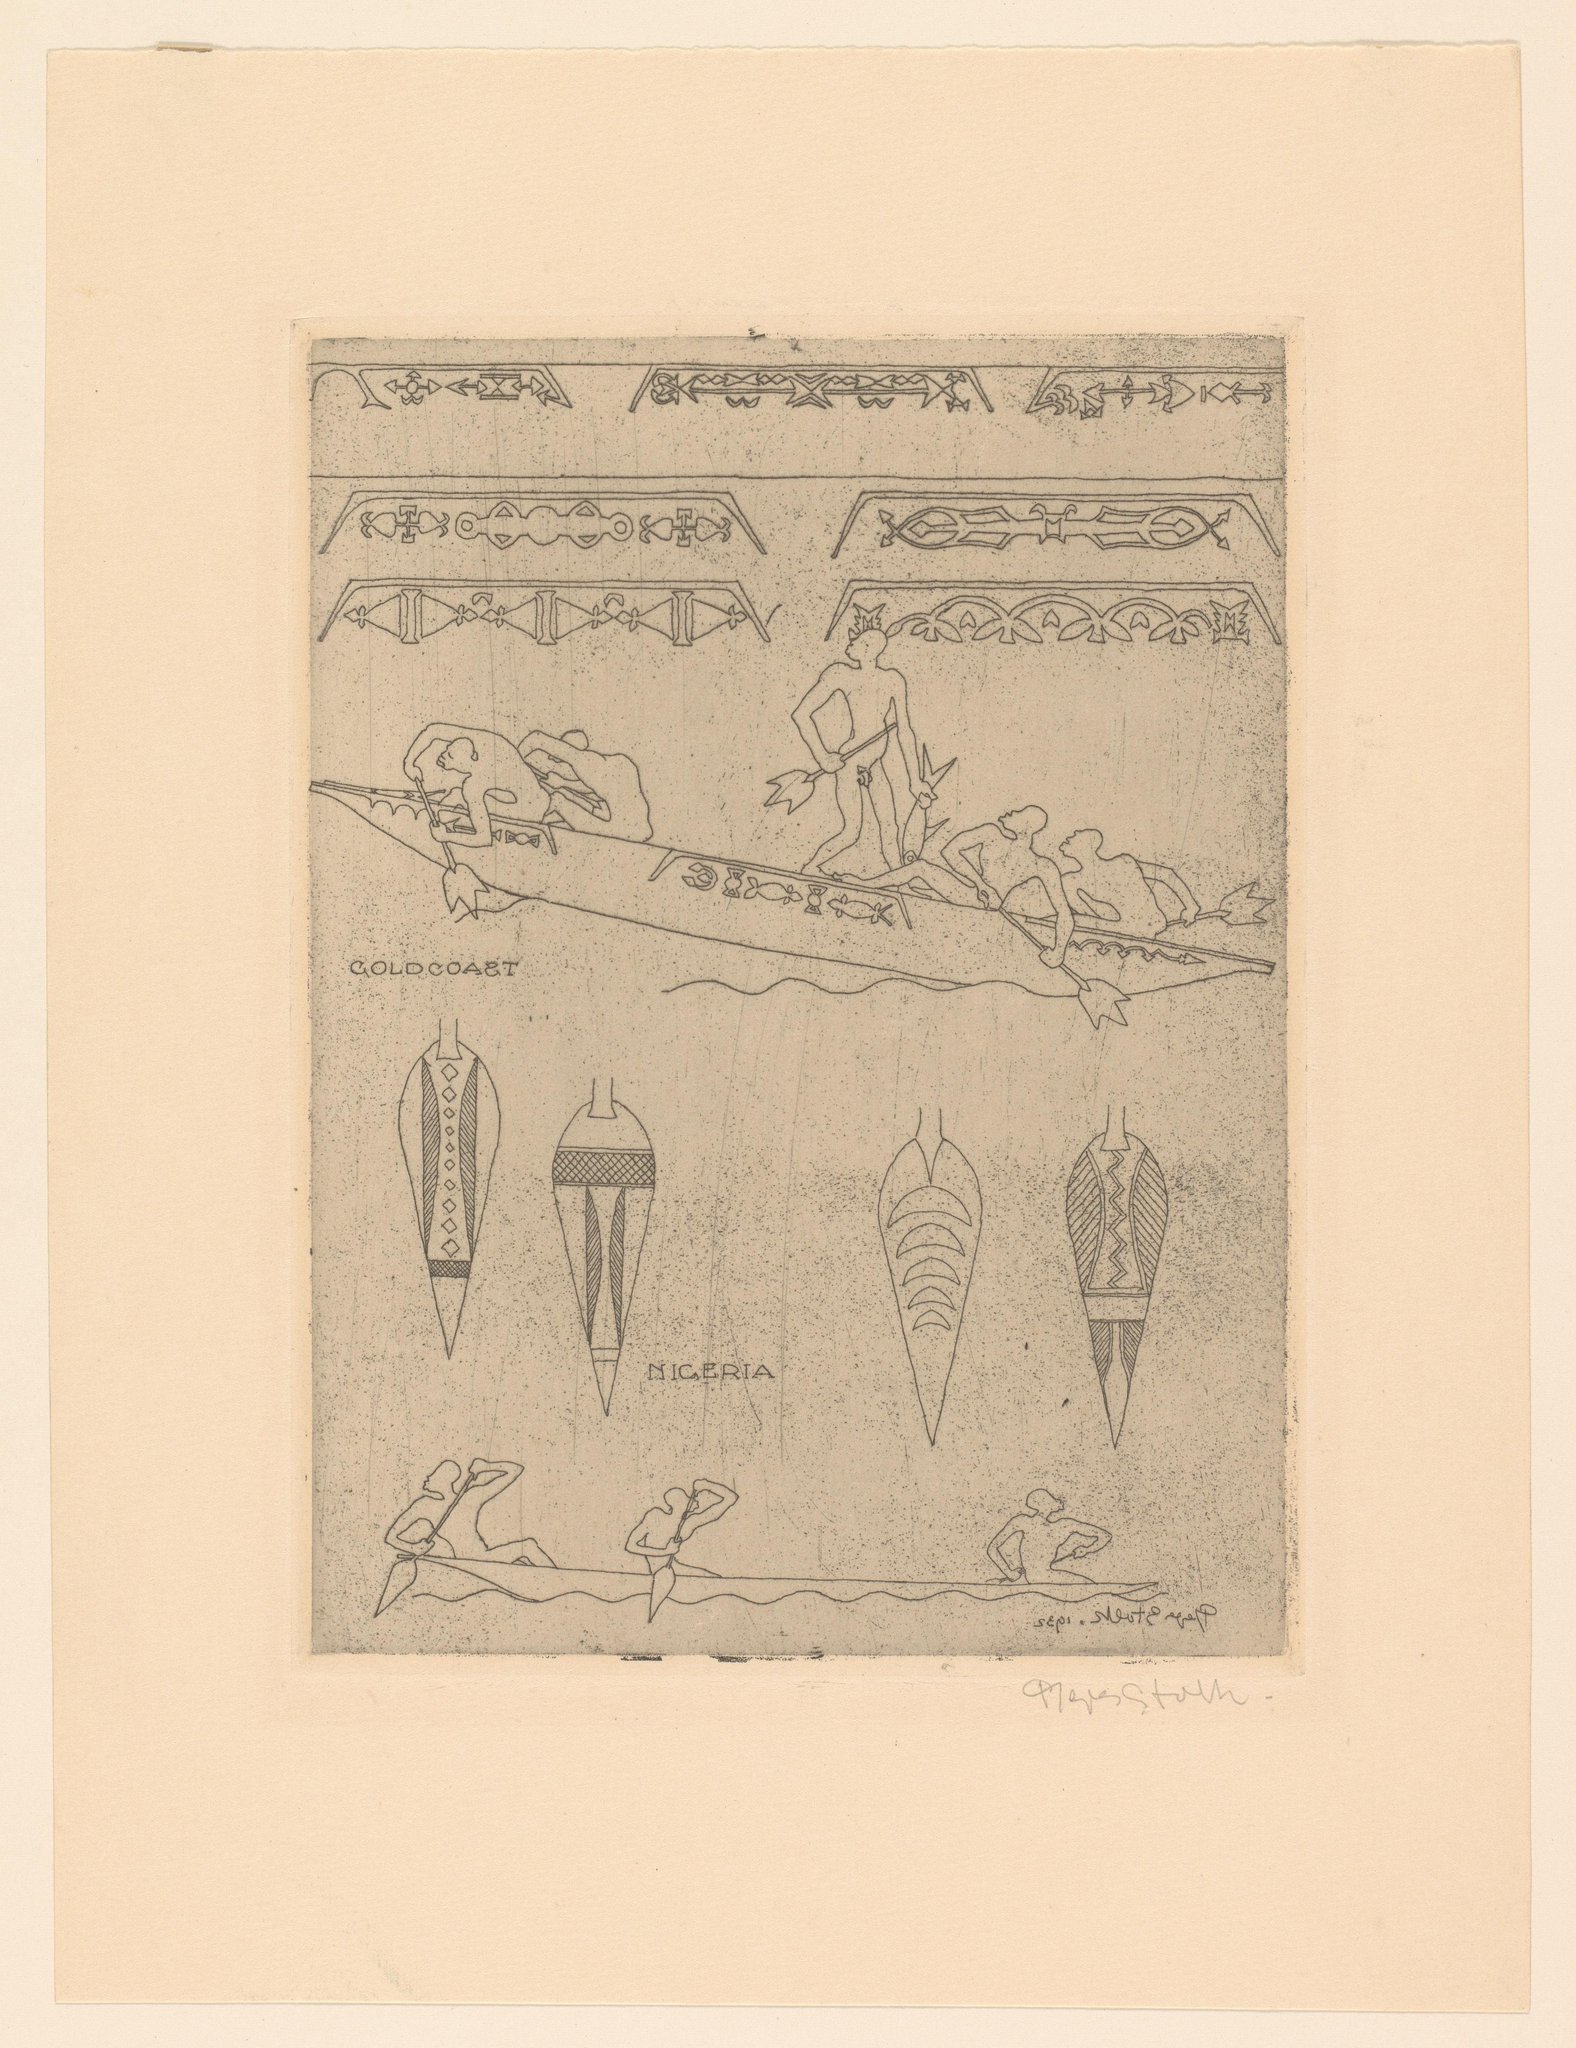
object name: print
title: Negers in prauwen, en randversieringen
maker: reijer stolk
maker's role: draughtsman, print maker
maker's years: 1896-1945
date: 1932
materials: paper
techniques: drypoint, etching, intaglio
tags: canoeing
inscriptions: collector's mark: Lugt 2228